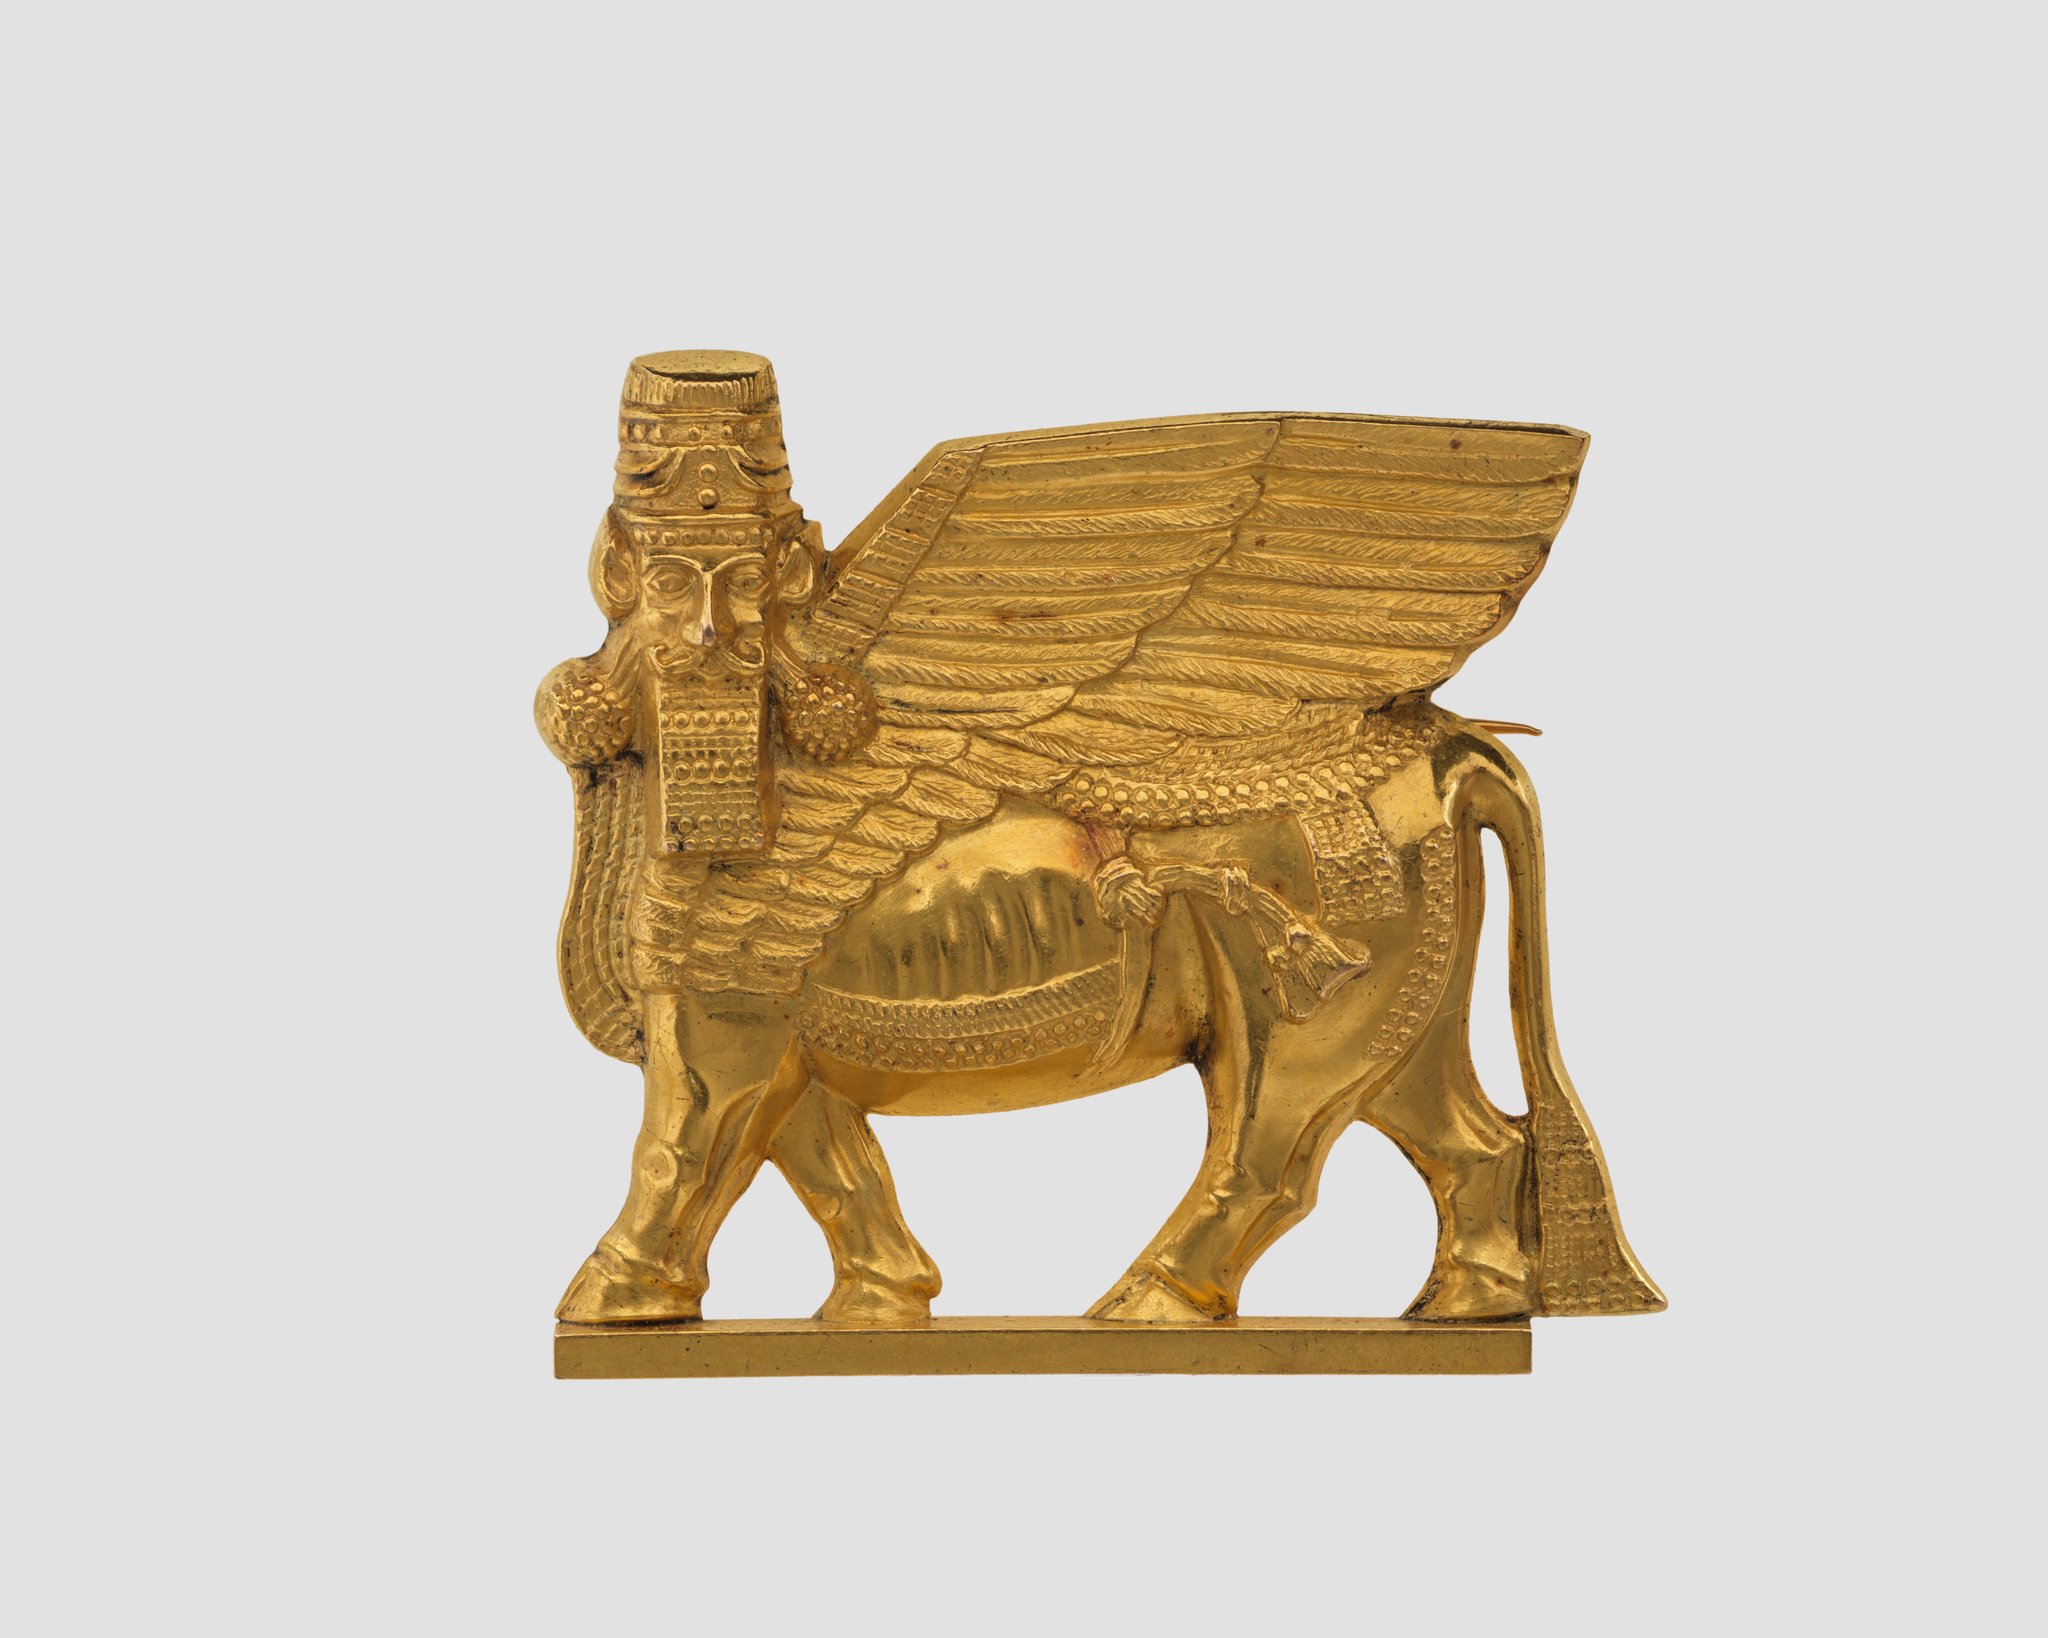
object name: brooch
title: Brooch with Assyrian human-headed winged bull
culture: british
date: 1850-1894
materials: gold